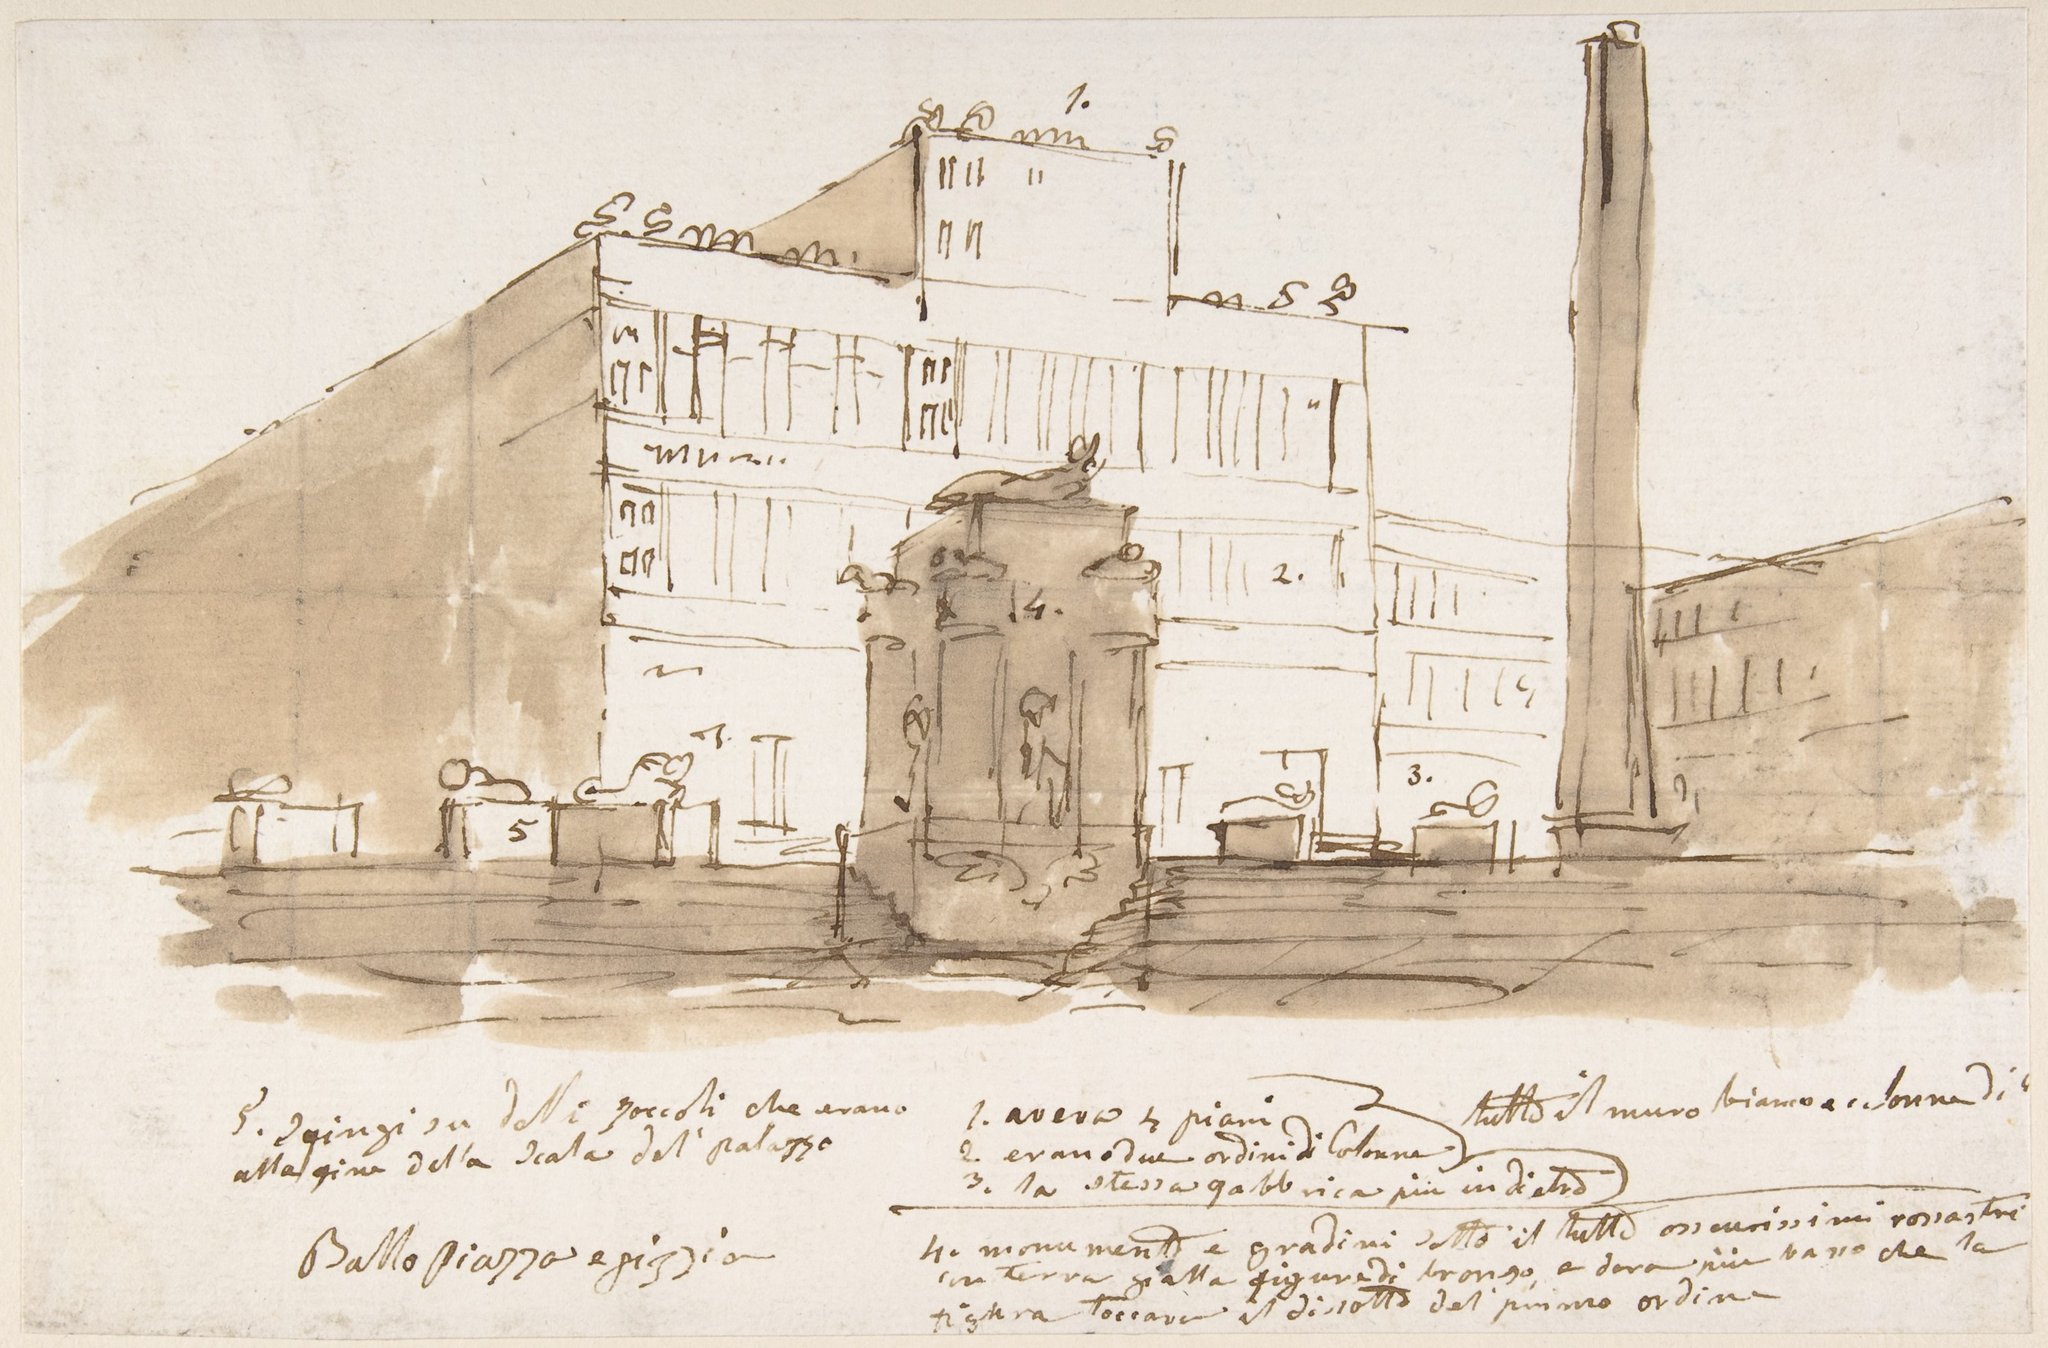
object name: drawing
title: Stage design: piazza with a building, an obelisk, and a monument. Building and monument with numbers referring to inscription below.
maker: anonymous, italian, venetian, 18th century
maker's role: artist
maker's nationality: italian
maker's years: 1700-1800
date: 1701-1800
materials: ink, paper, lead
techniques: brush, pen, wash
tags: buildings,monuments,obelisks